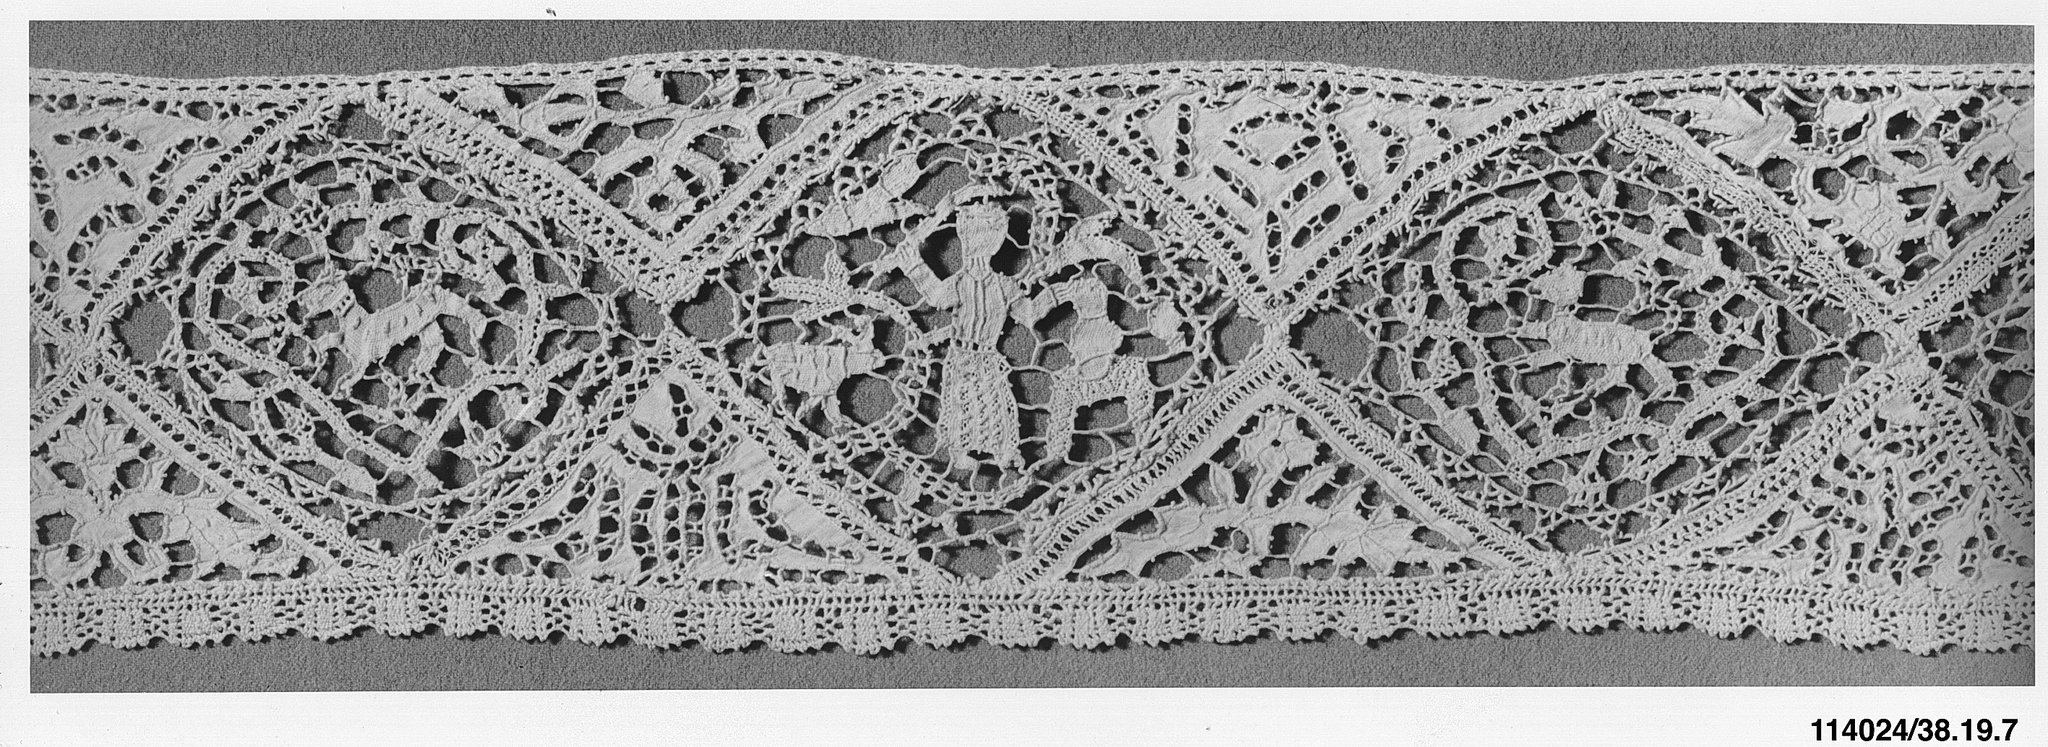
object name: border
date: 1501-1600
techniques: embroidery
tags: human figures,animals